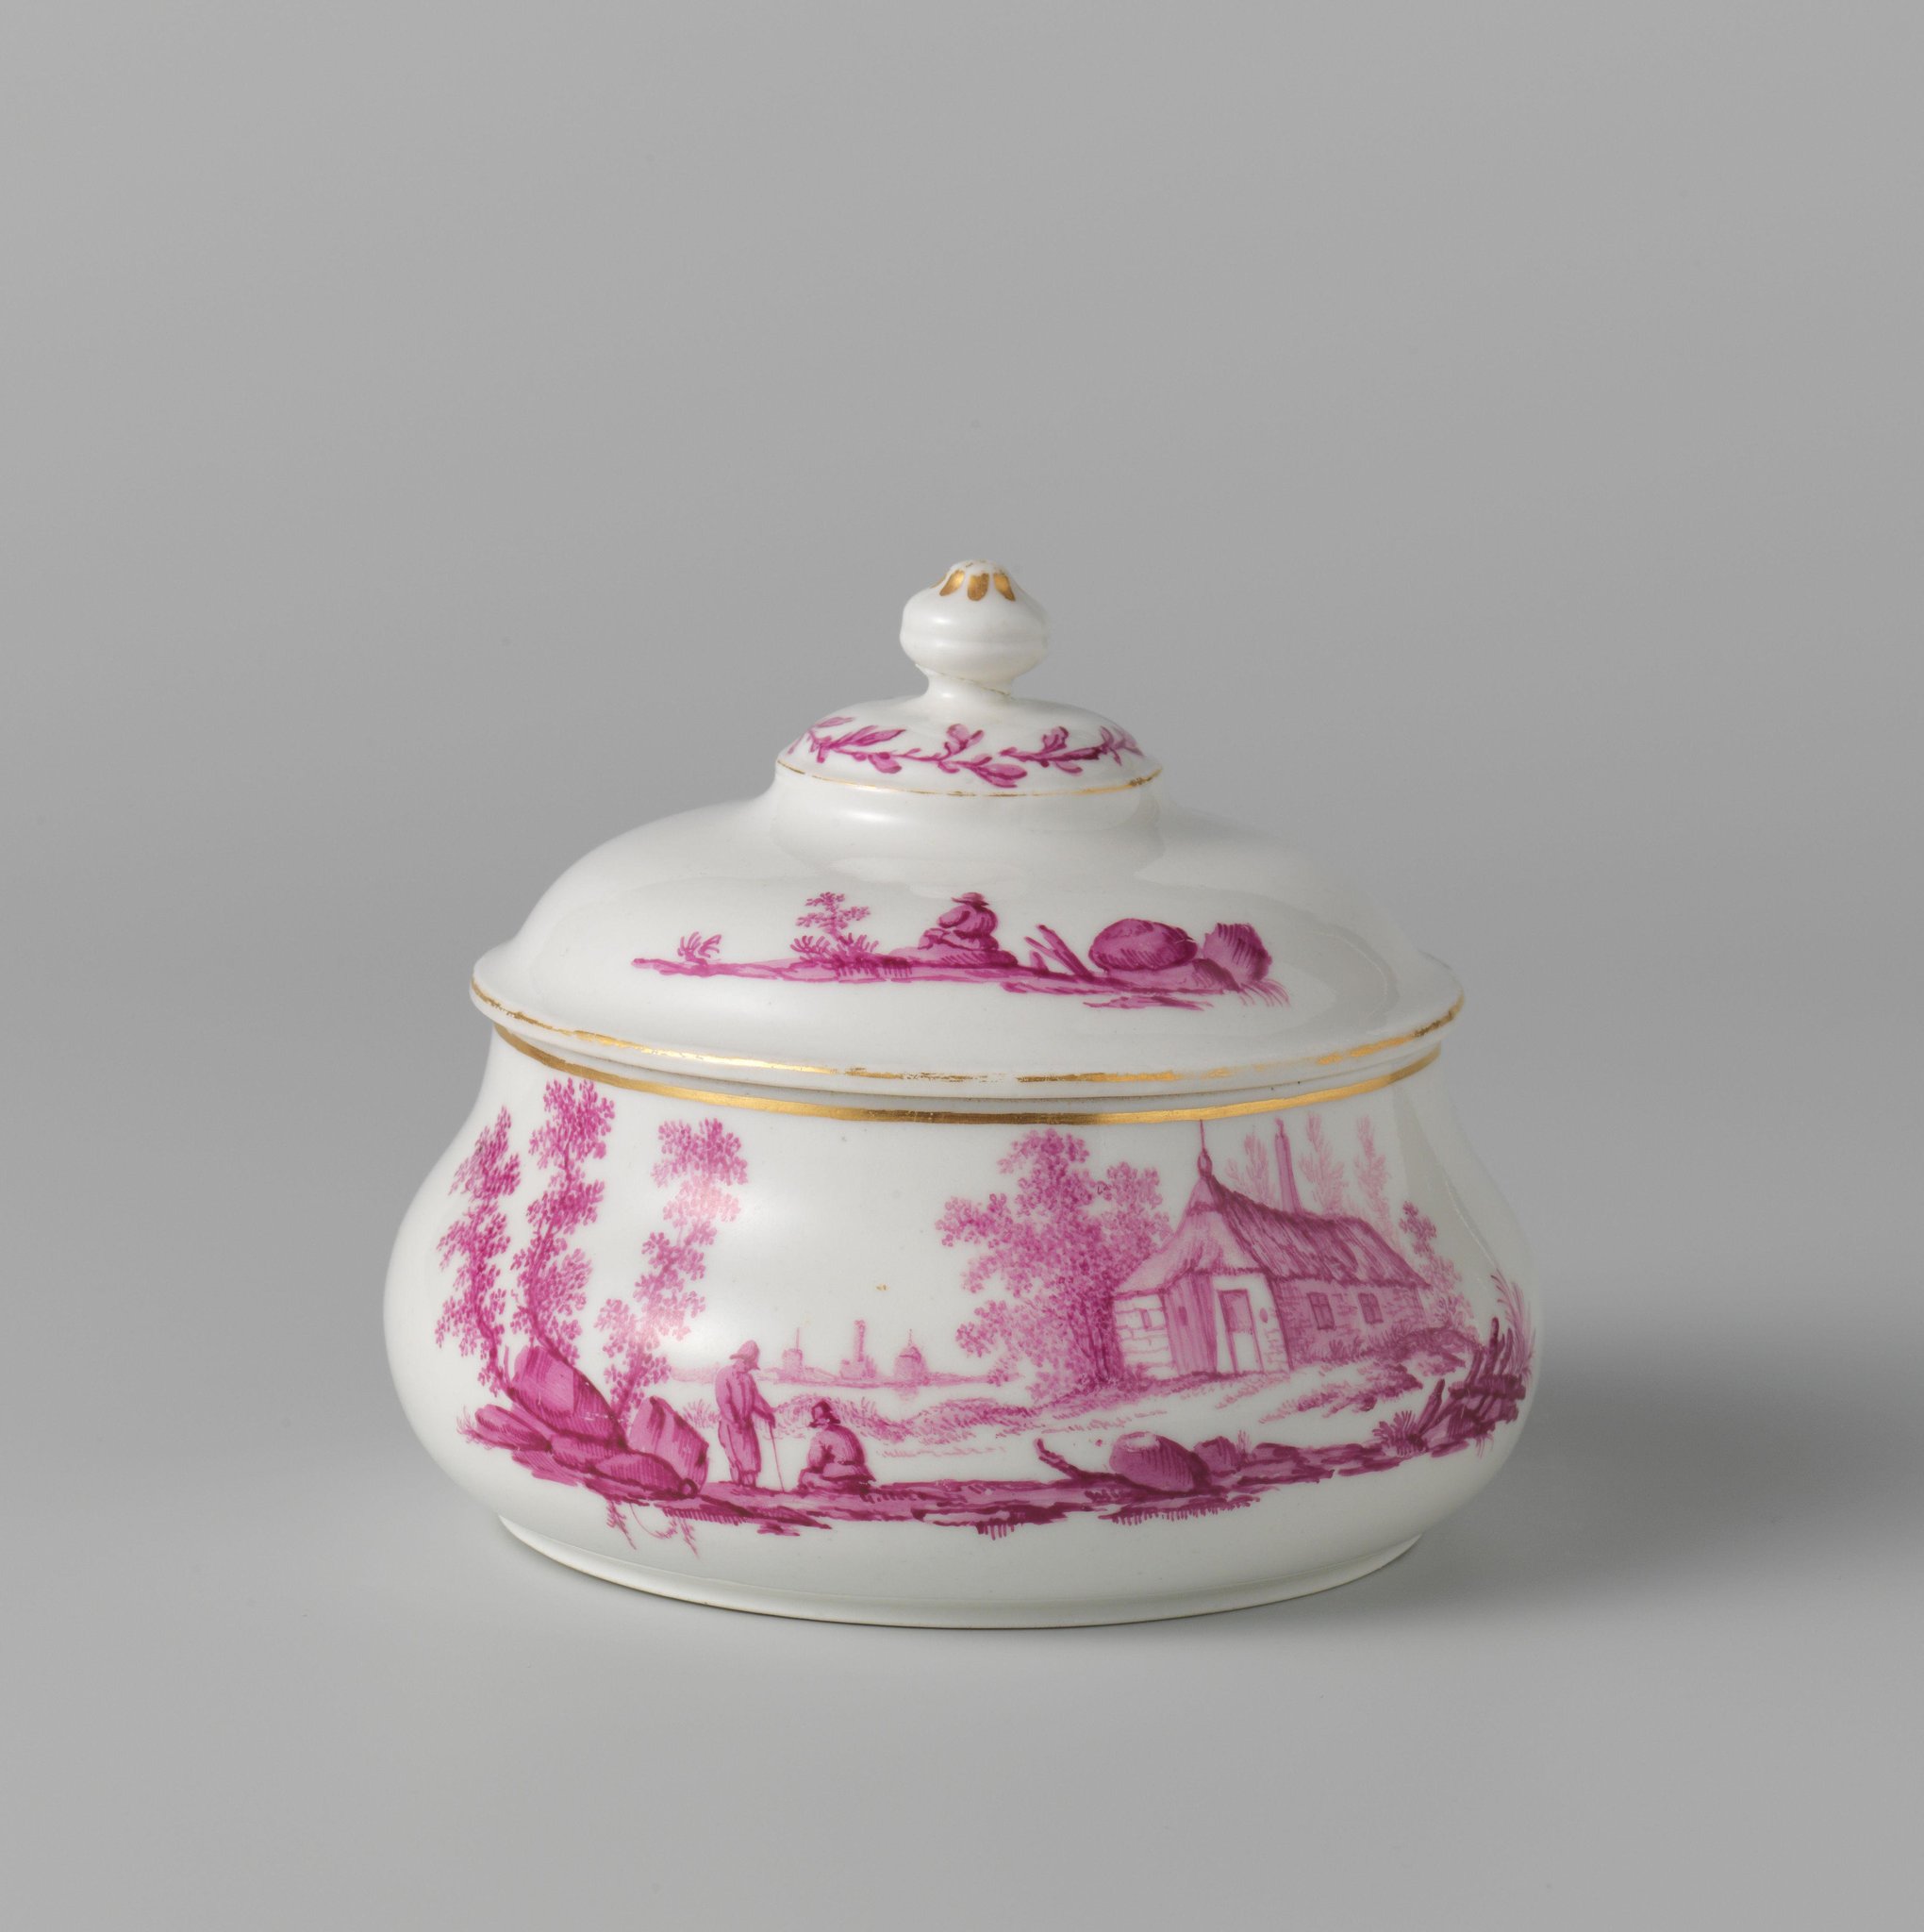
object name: lid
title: Deksel van een tabakspot, beschilderd met figuren in een landschap met boerderij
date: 1774-1778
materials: porcelain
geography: loosdrecht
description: Deksel van porselein, beschilderd in bietenrood met figuren in een landschap met boerderij. Op het deksel een man zittend op een grondje, op de achterkant van beide delen een grondje. Rondom de dekselknop, die versierd is met een rozet in goud, een bladkrans in bietenrood. Mond- en dekselrand voorzien van een gouden bies.